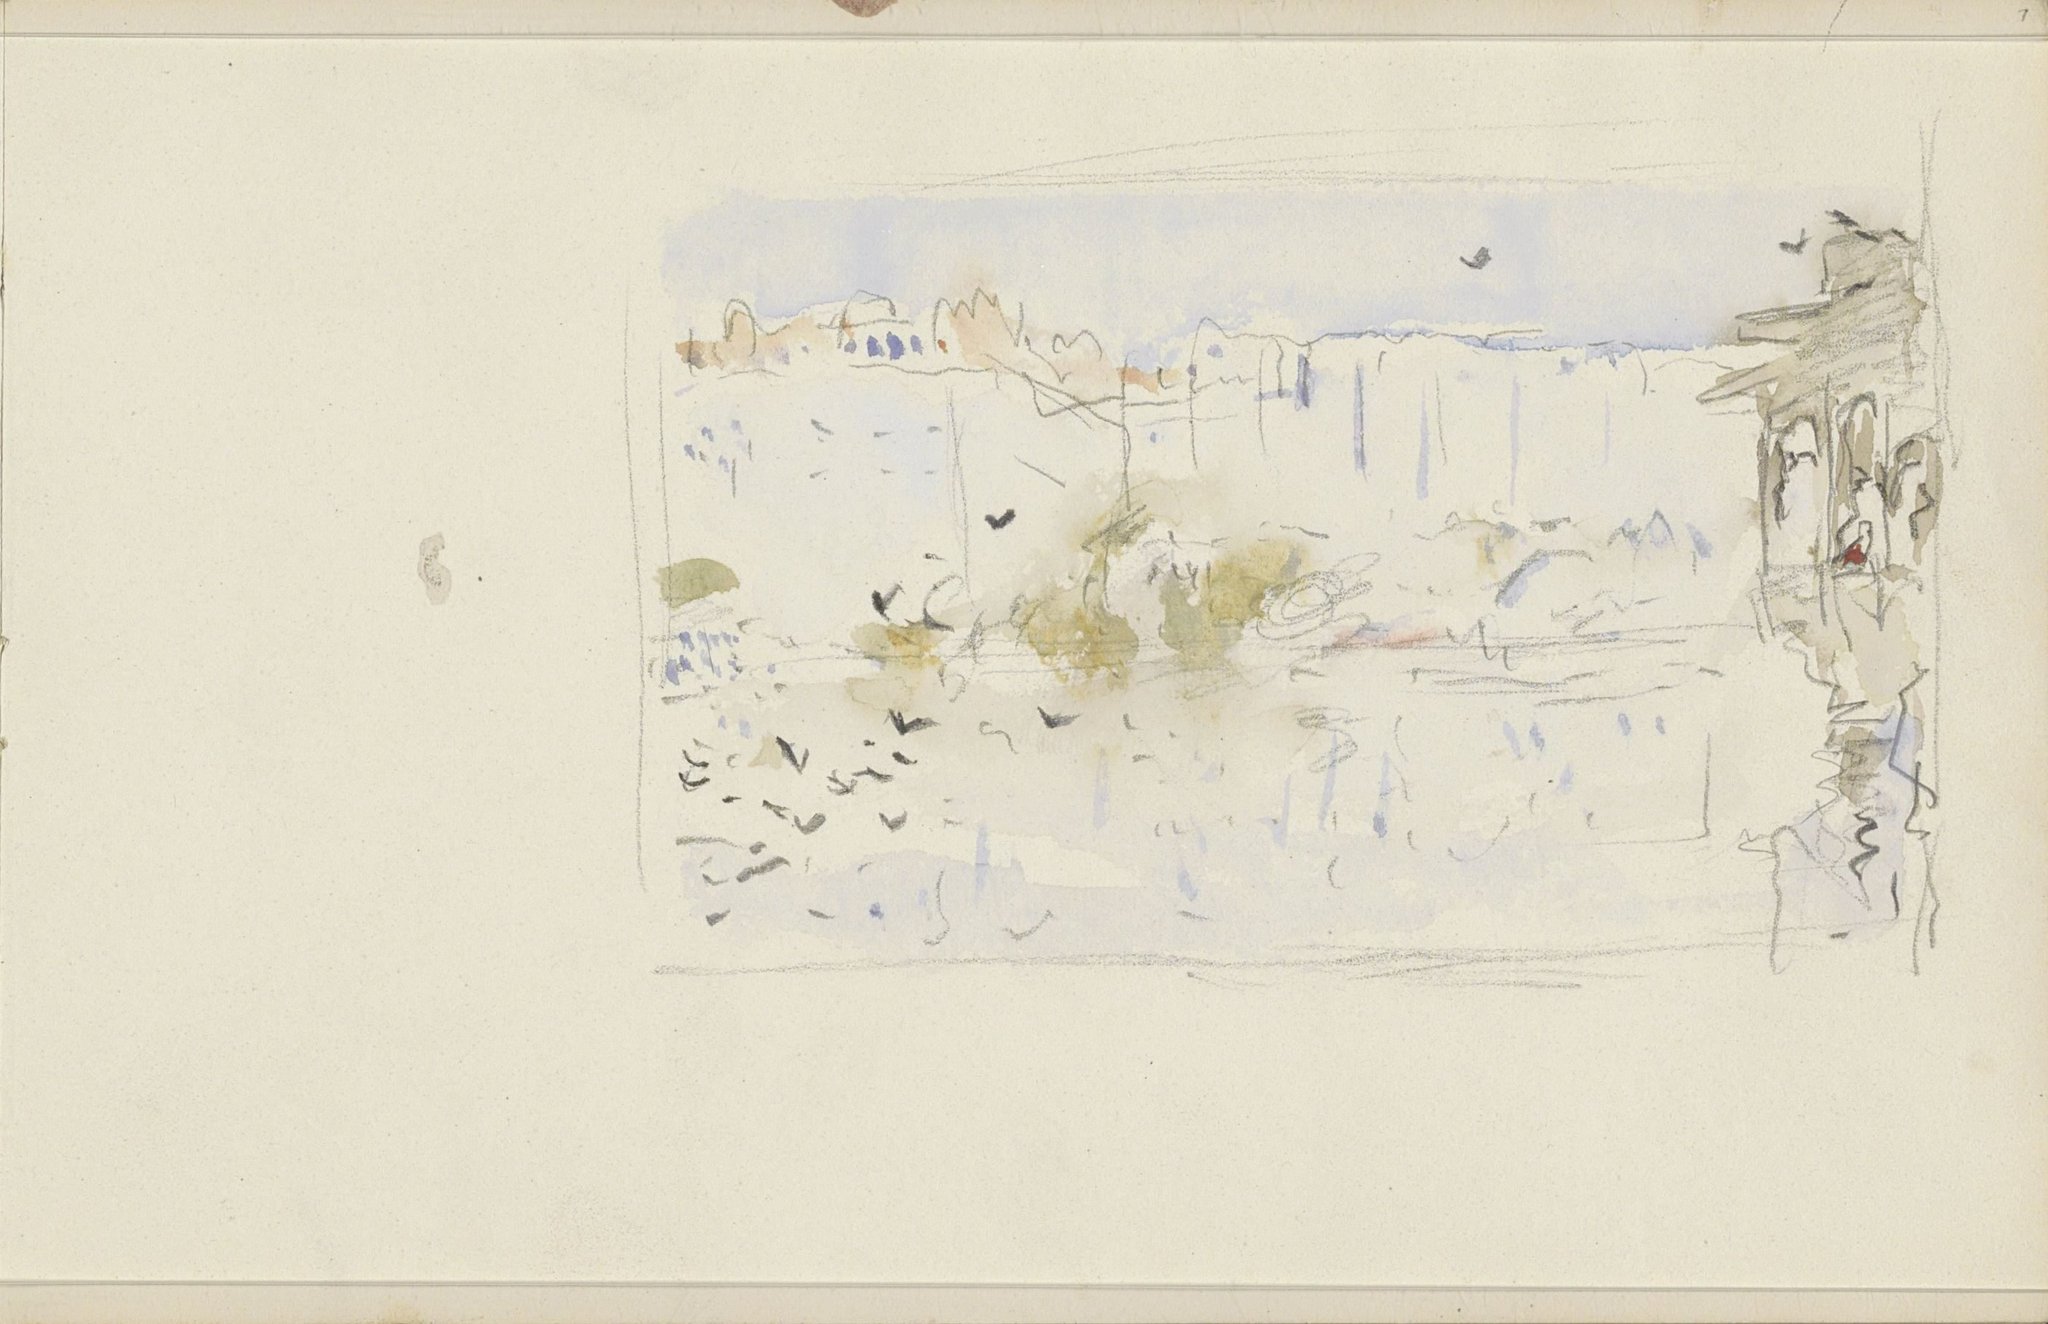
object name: sketchbook leaf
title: Stadspaleis van Udaipur vanaf het Pichola-meer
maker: marius bauer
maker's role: draughtsman, print maker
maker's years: 1867-1932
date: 1924-1925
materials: paper, pencil, watercolor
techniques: brush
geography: udaipur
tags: city-view, and landscape with man-made constructions, lake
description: Pagina 7 uit een schetsboek met 48 bladen.